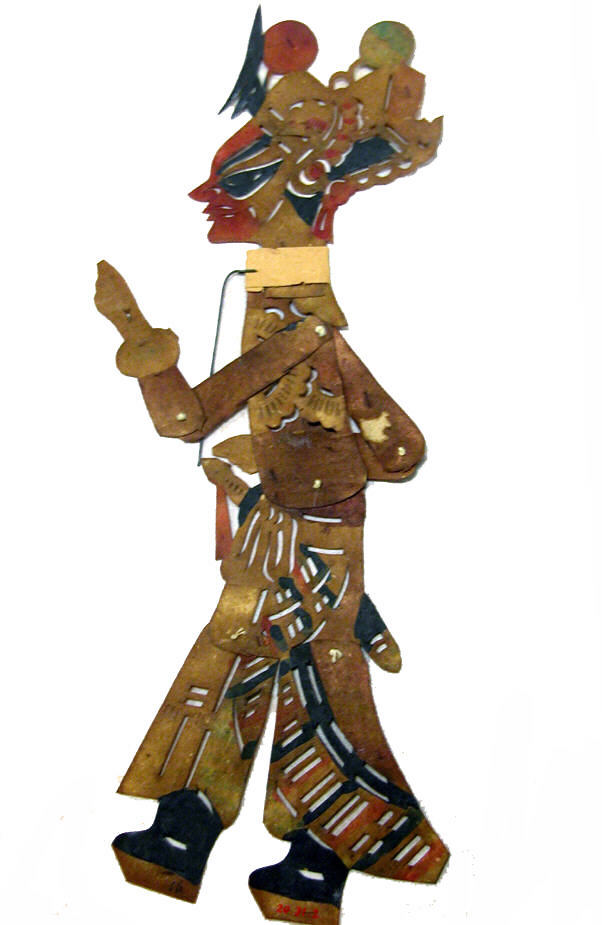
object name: shadow player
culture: chinese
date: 1801-1900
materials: cord, skin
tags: swords,men